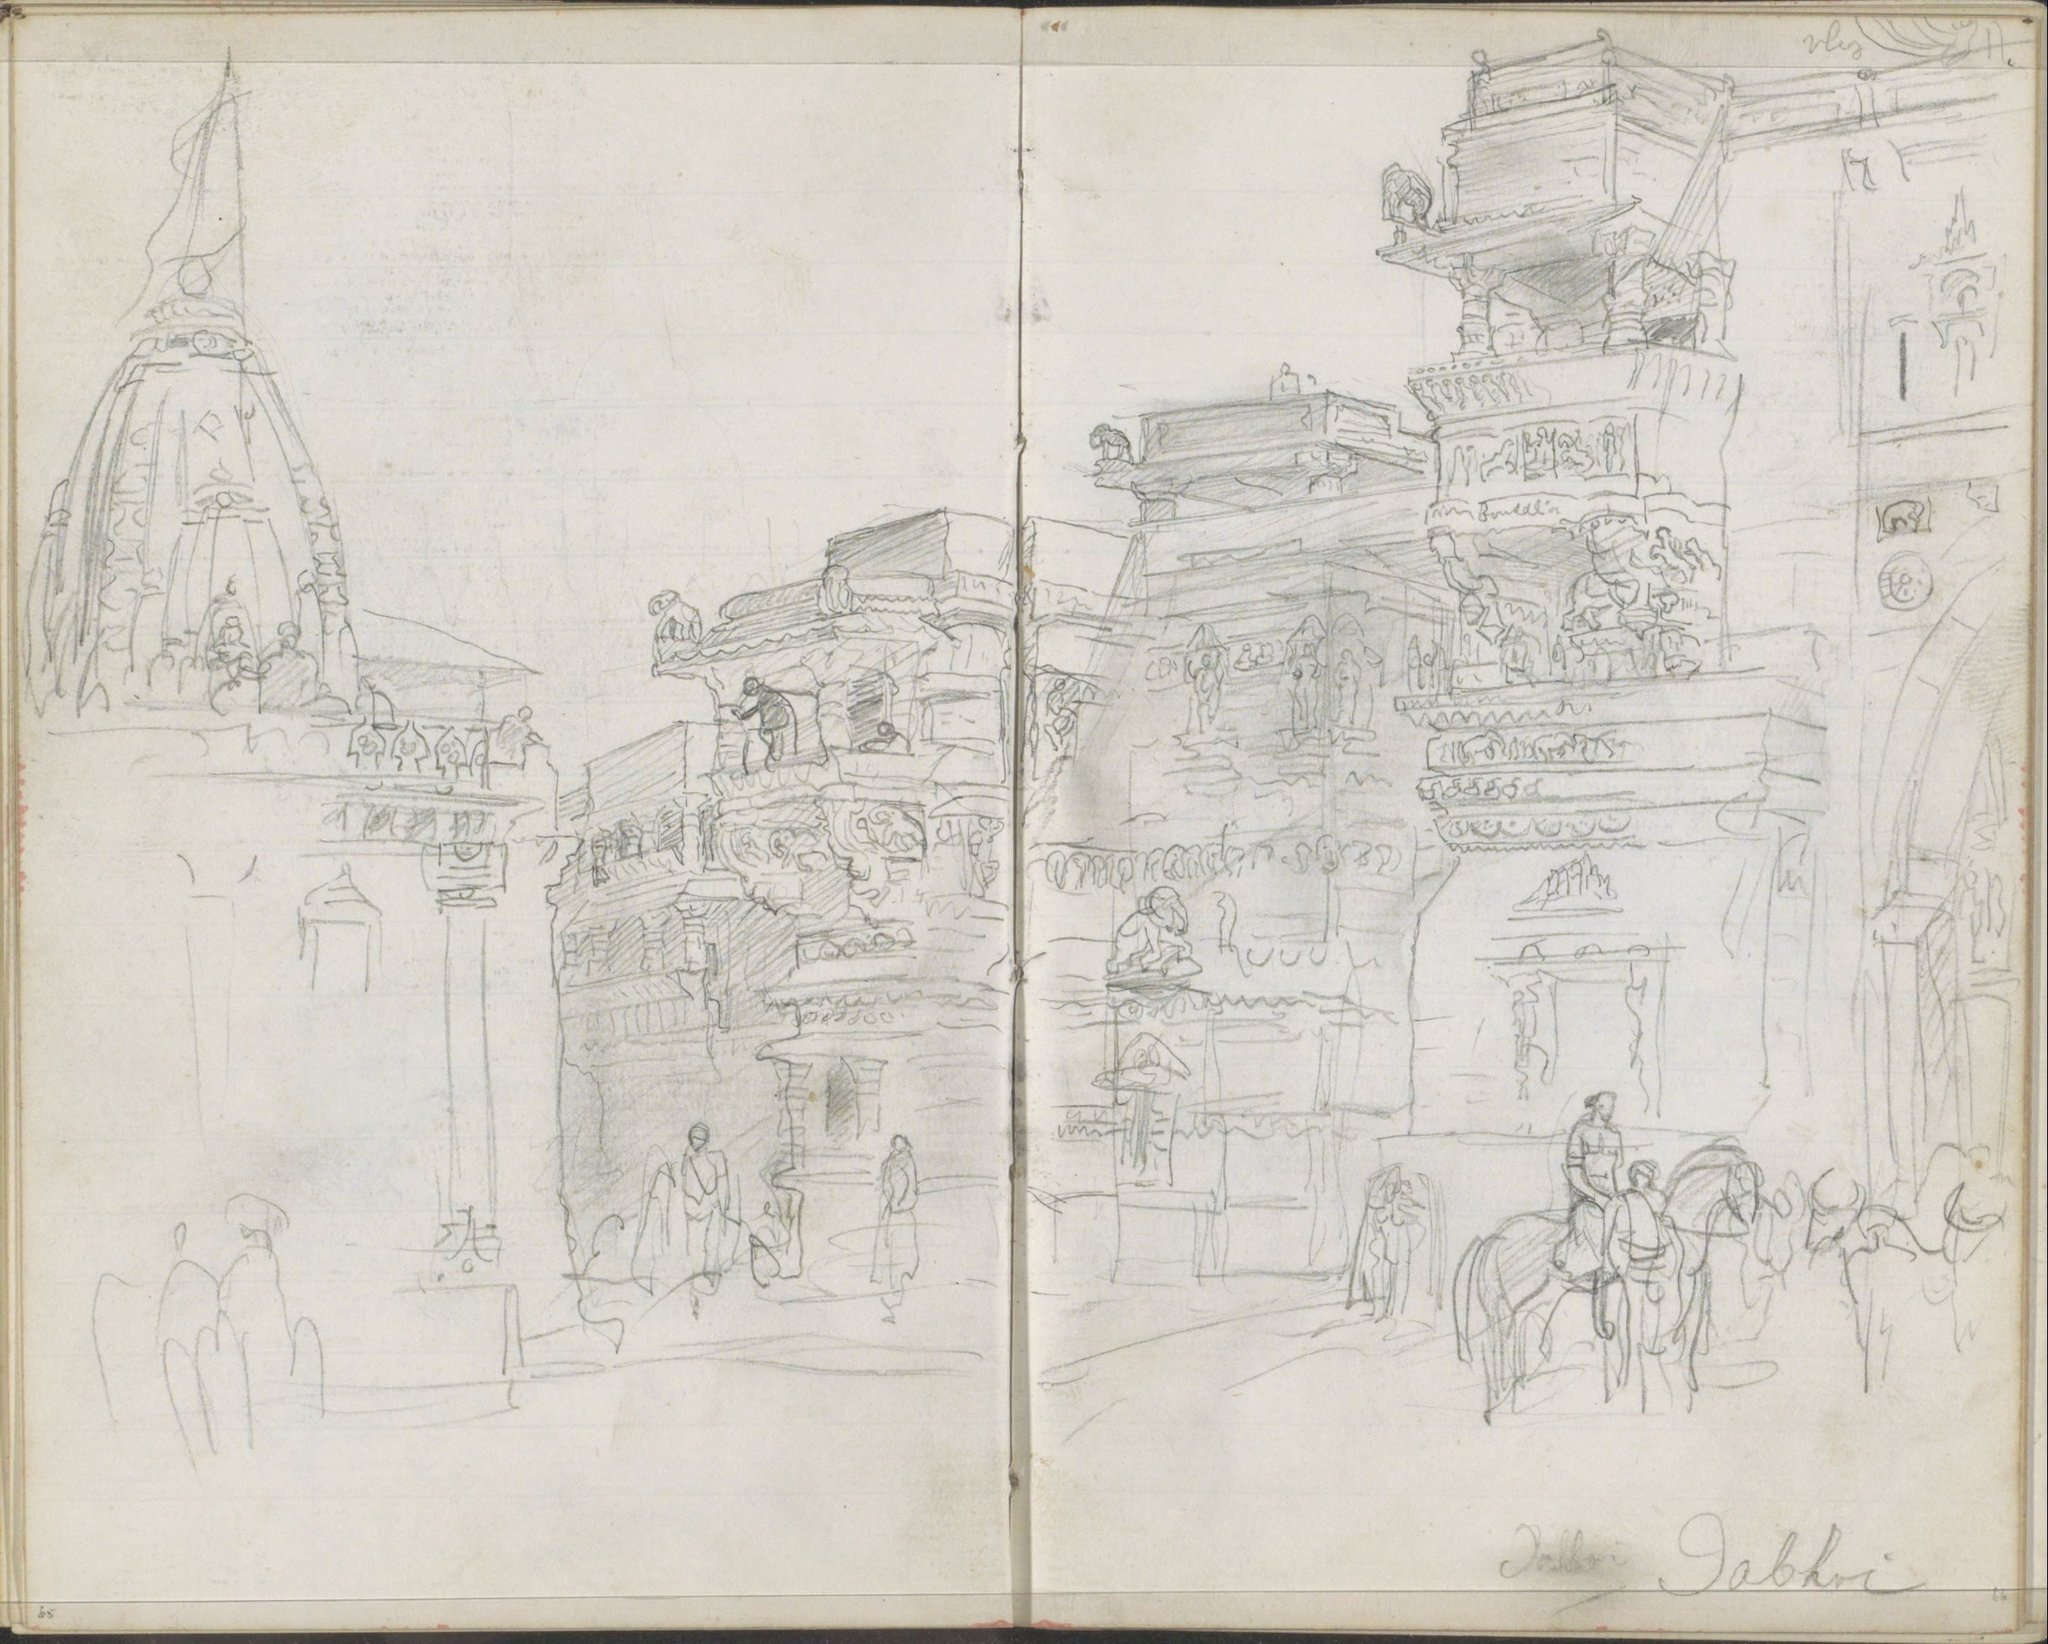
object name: sketchbook leaf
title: Muur van het Dabhoi fort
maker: marius bauer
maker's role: draughtsman, print maker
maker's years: 1867-1932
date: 1897-1898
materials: pencil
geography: gujarat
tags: standing figure, walls ~ fortified city, sculpture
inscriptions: annotation: ‘Dahboi Dabhoi’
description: De muur bevat ornamenteel beeldhouwwerk, dat onder andere olifanten uitbeeldt. Pagina 65 en 66 uit een schetsboek met 62 bladen.